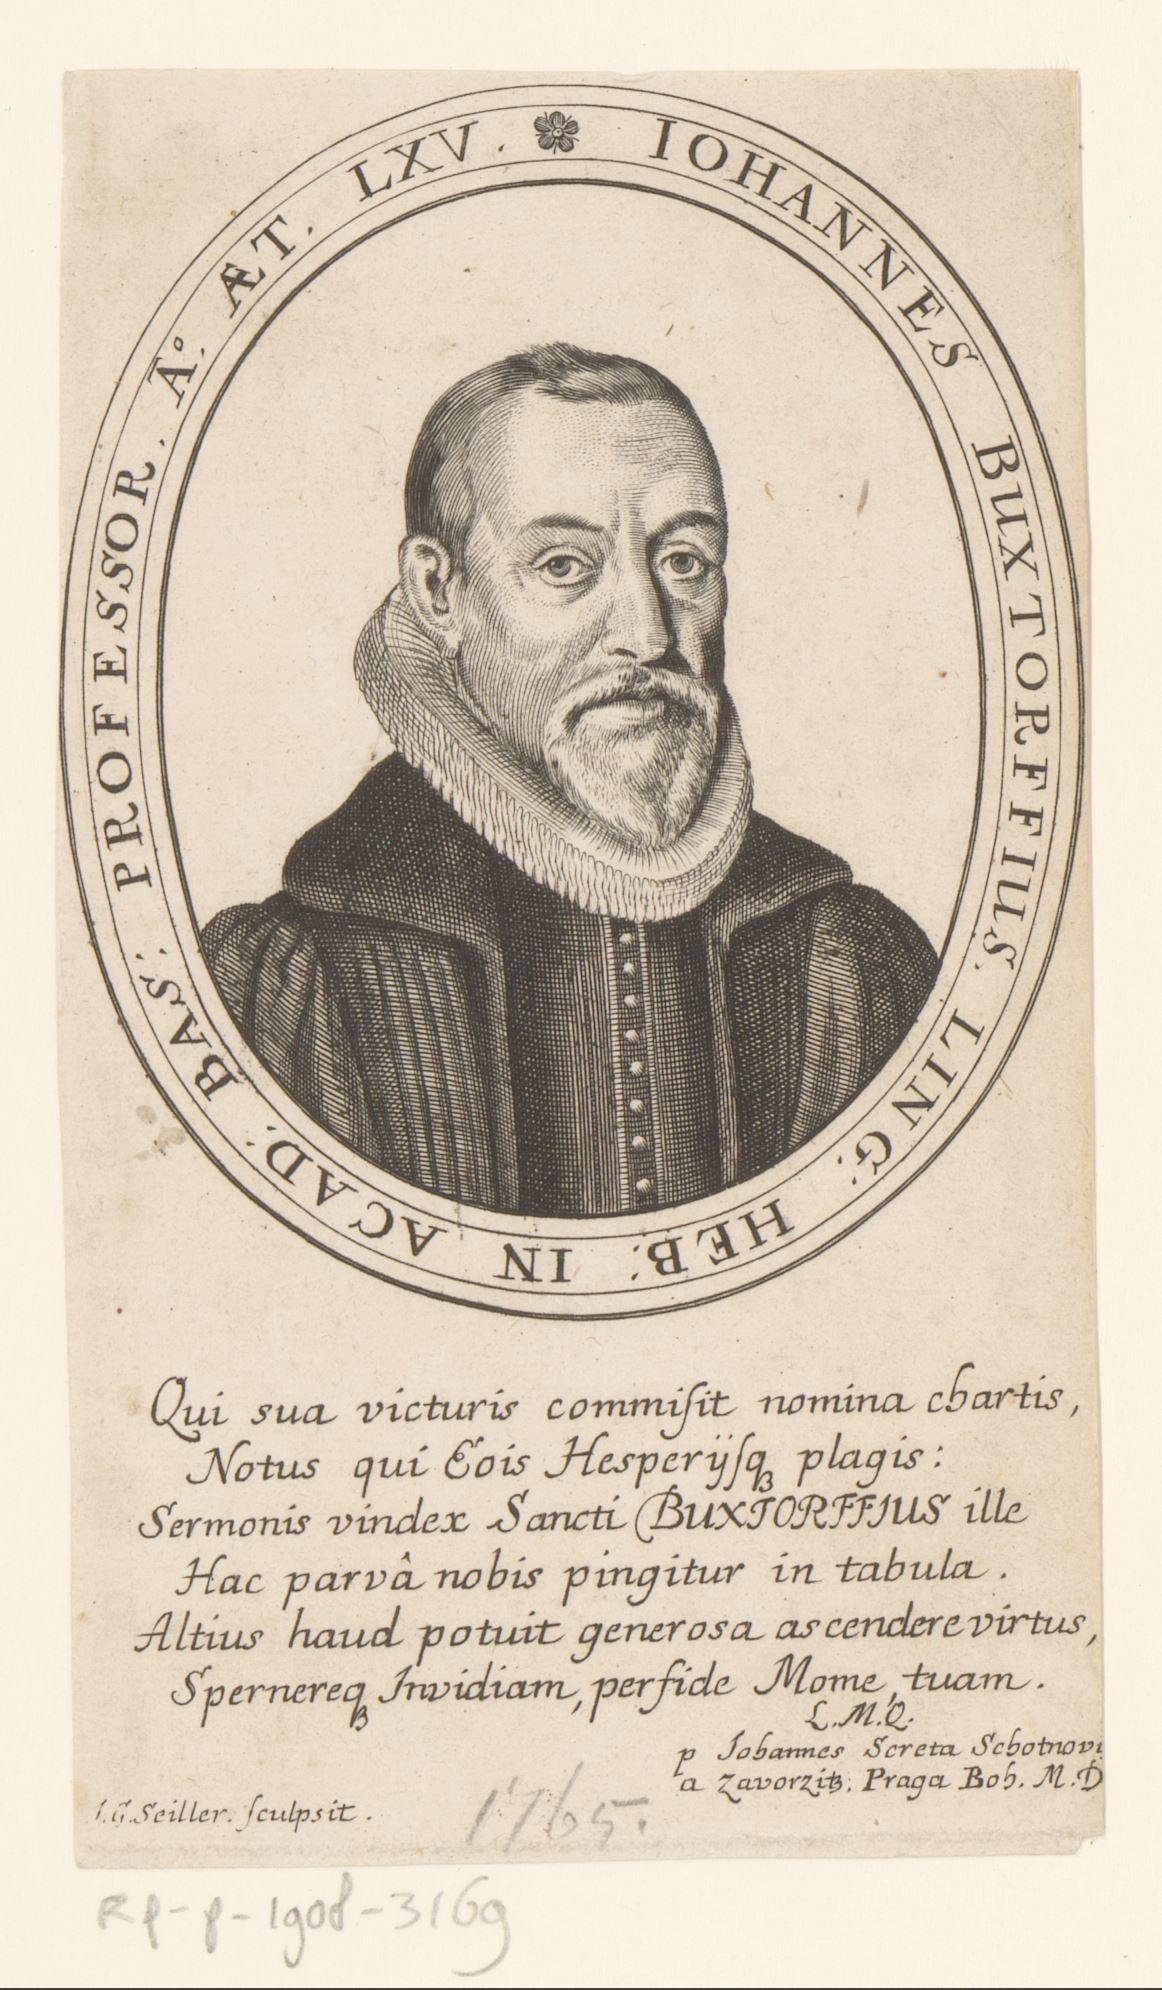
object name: print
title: Portret van Johannes Buxtorf de oude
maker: johann georg seiller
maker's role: print maker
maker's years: 1663-1740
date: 1673-1740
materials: paper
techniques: engraving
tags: johannes buxtorf de oude, historical persons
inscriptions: collector's mark: Lugt 2228